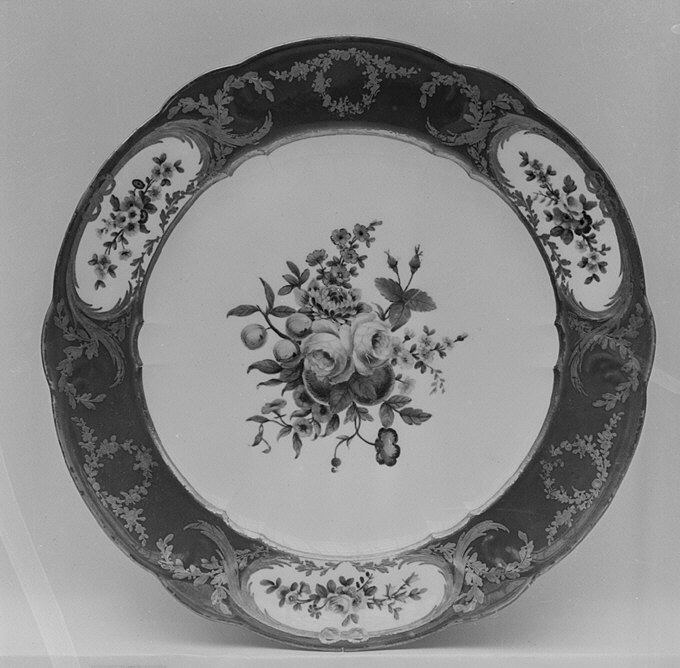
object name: plate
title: Plate (part of a service)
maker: sèvres manufactory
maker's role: manufactory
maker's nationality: french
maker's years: 1740-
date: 1784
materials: soft paste porcelain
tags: flowers